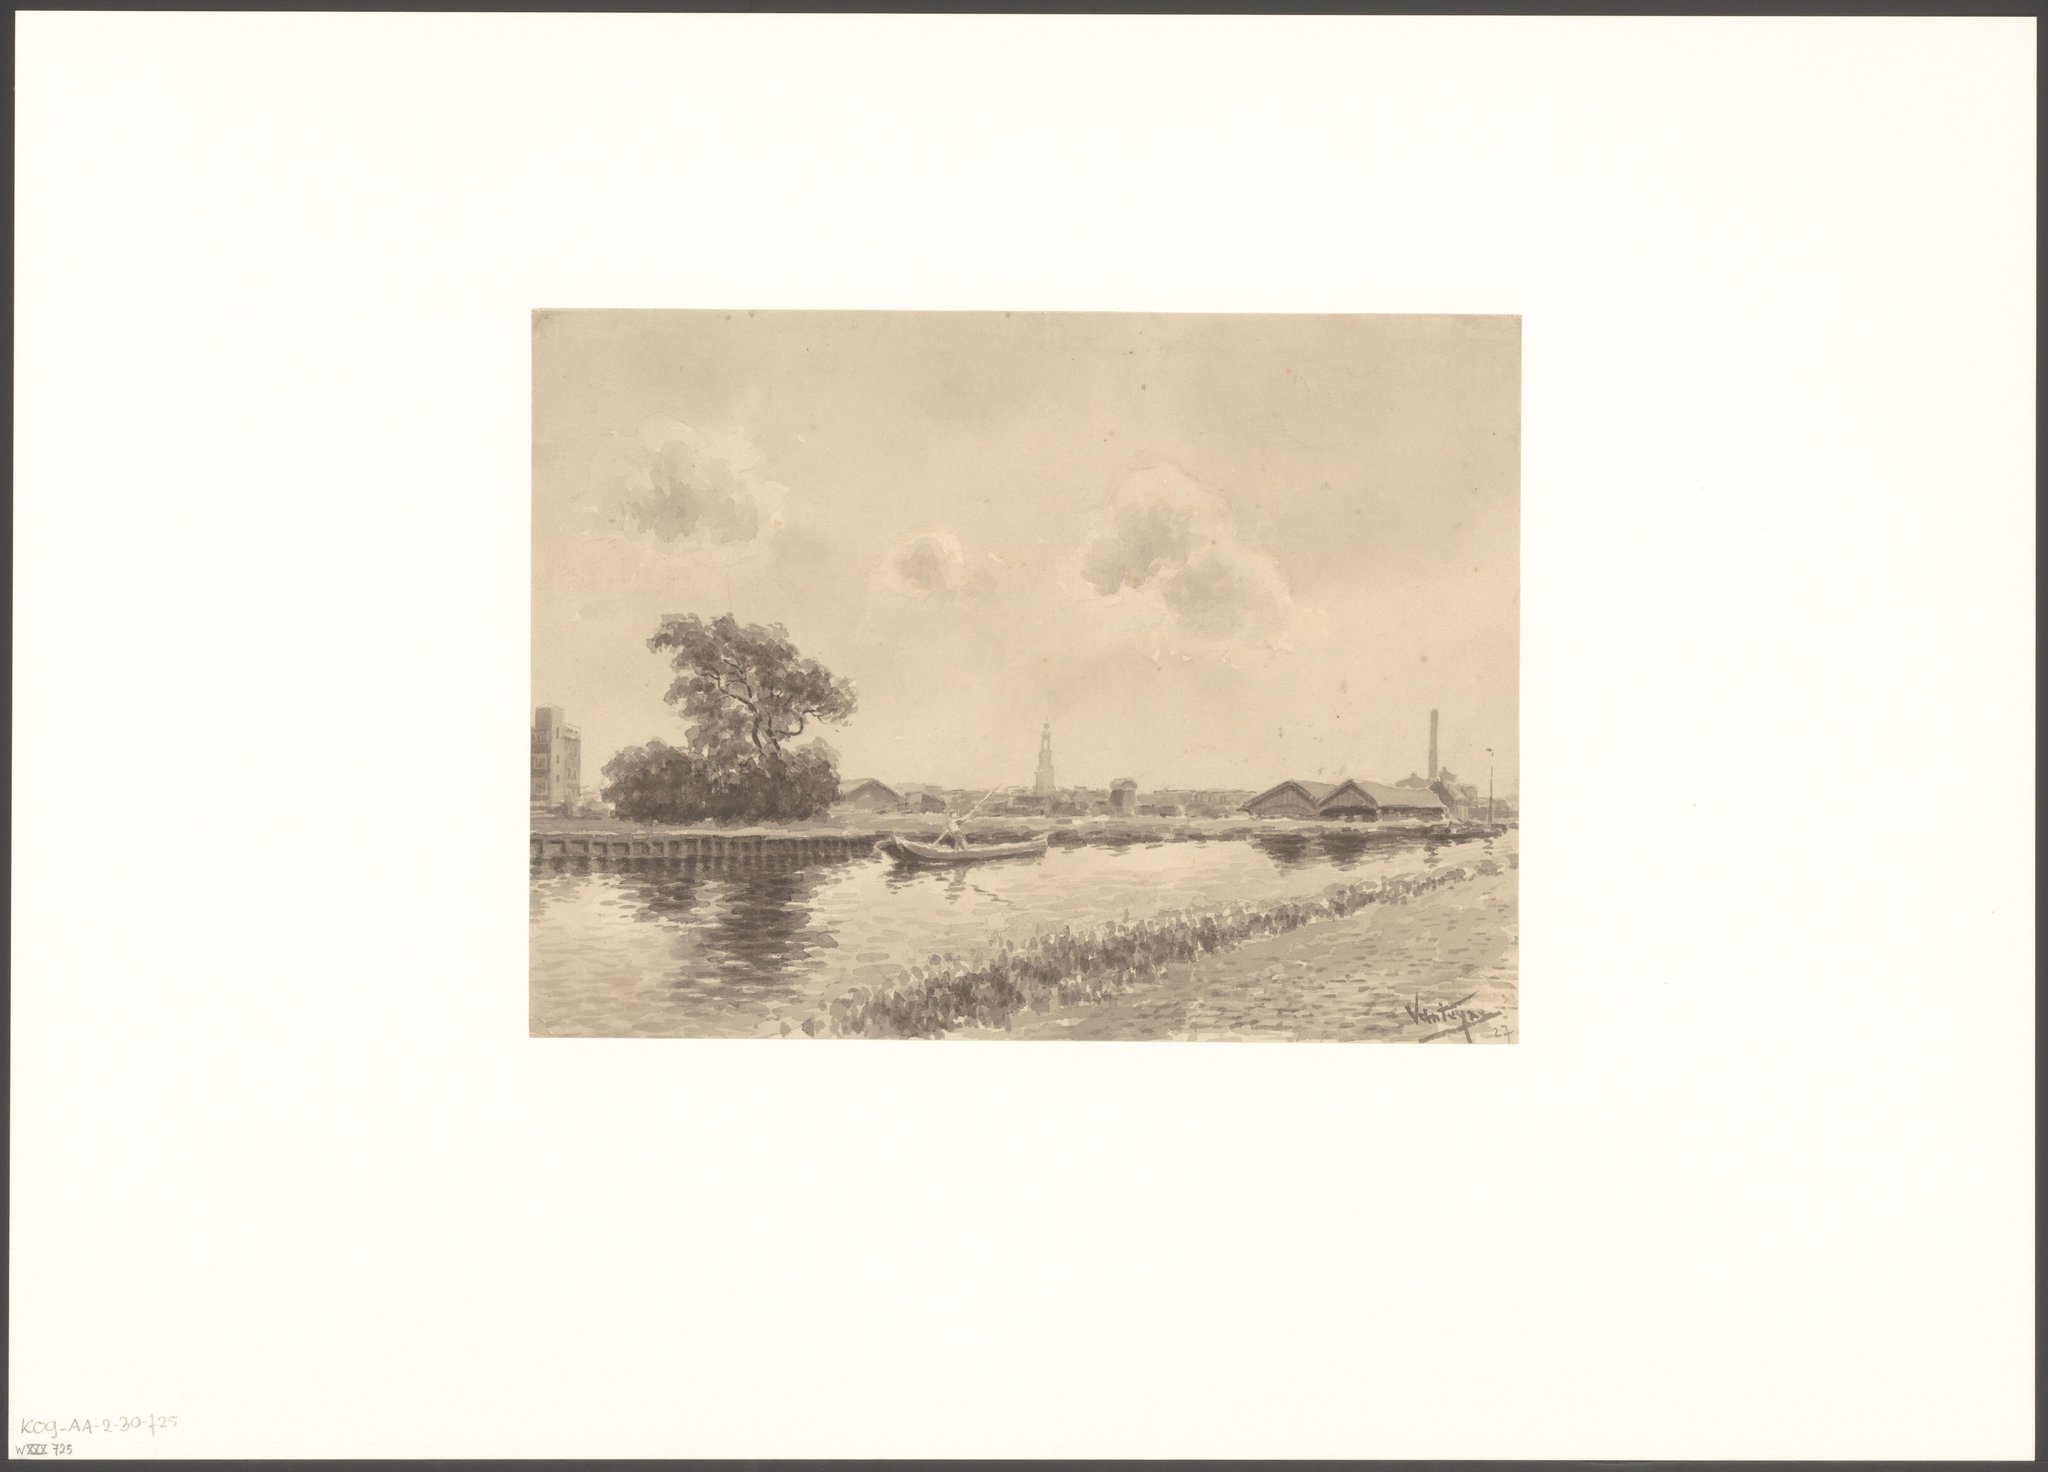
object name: drawing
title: Gezicht op de voormalige vuilnisbelt bij de Buyskade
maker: anthonie van teijn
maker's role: draughtsman, painter, print maker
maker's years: 1863-1943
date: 1907-1927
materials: ink, paper, pencil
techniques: brush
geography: amsterdam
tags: tower, clock tower ~ monumental adornment, city-view in general; 'veduta', canal, garbage collection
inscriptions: signature and date: ‘VanTeyne / 27’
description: Tekening binnen de Atlas Van Eck ingedeeld op wijknummer 30.